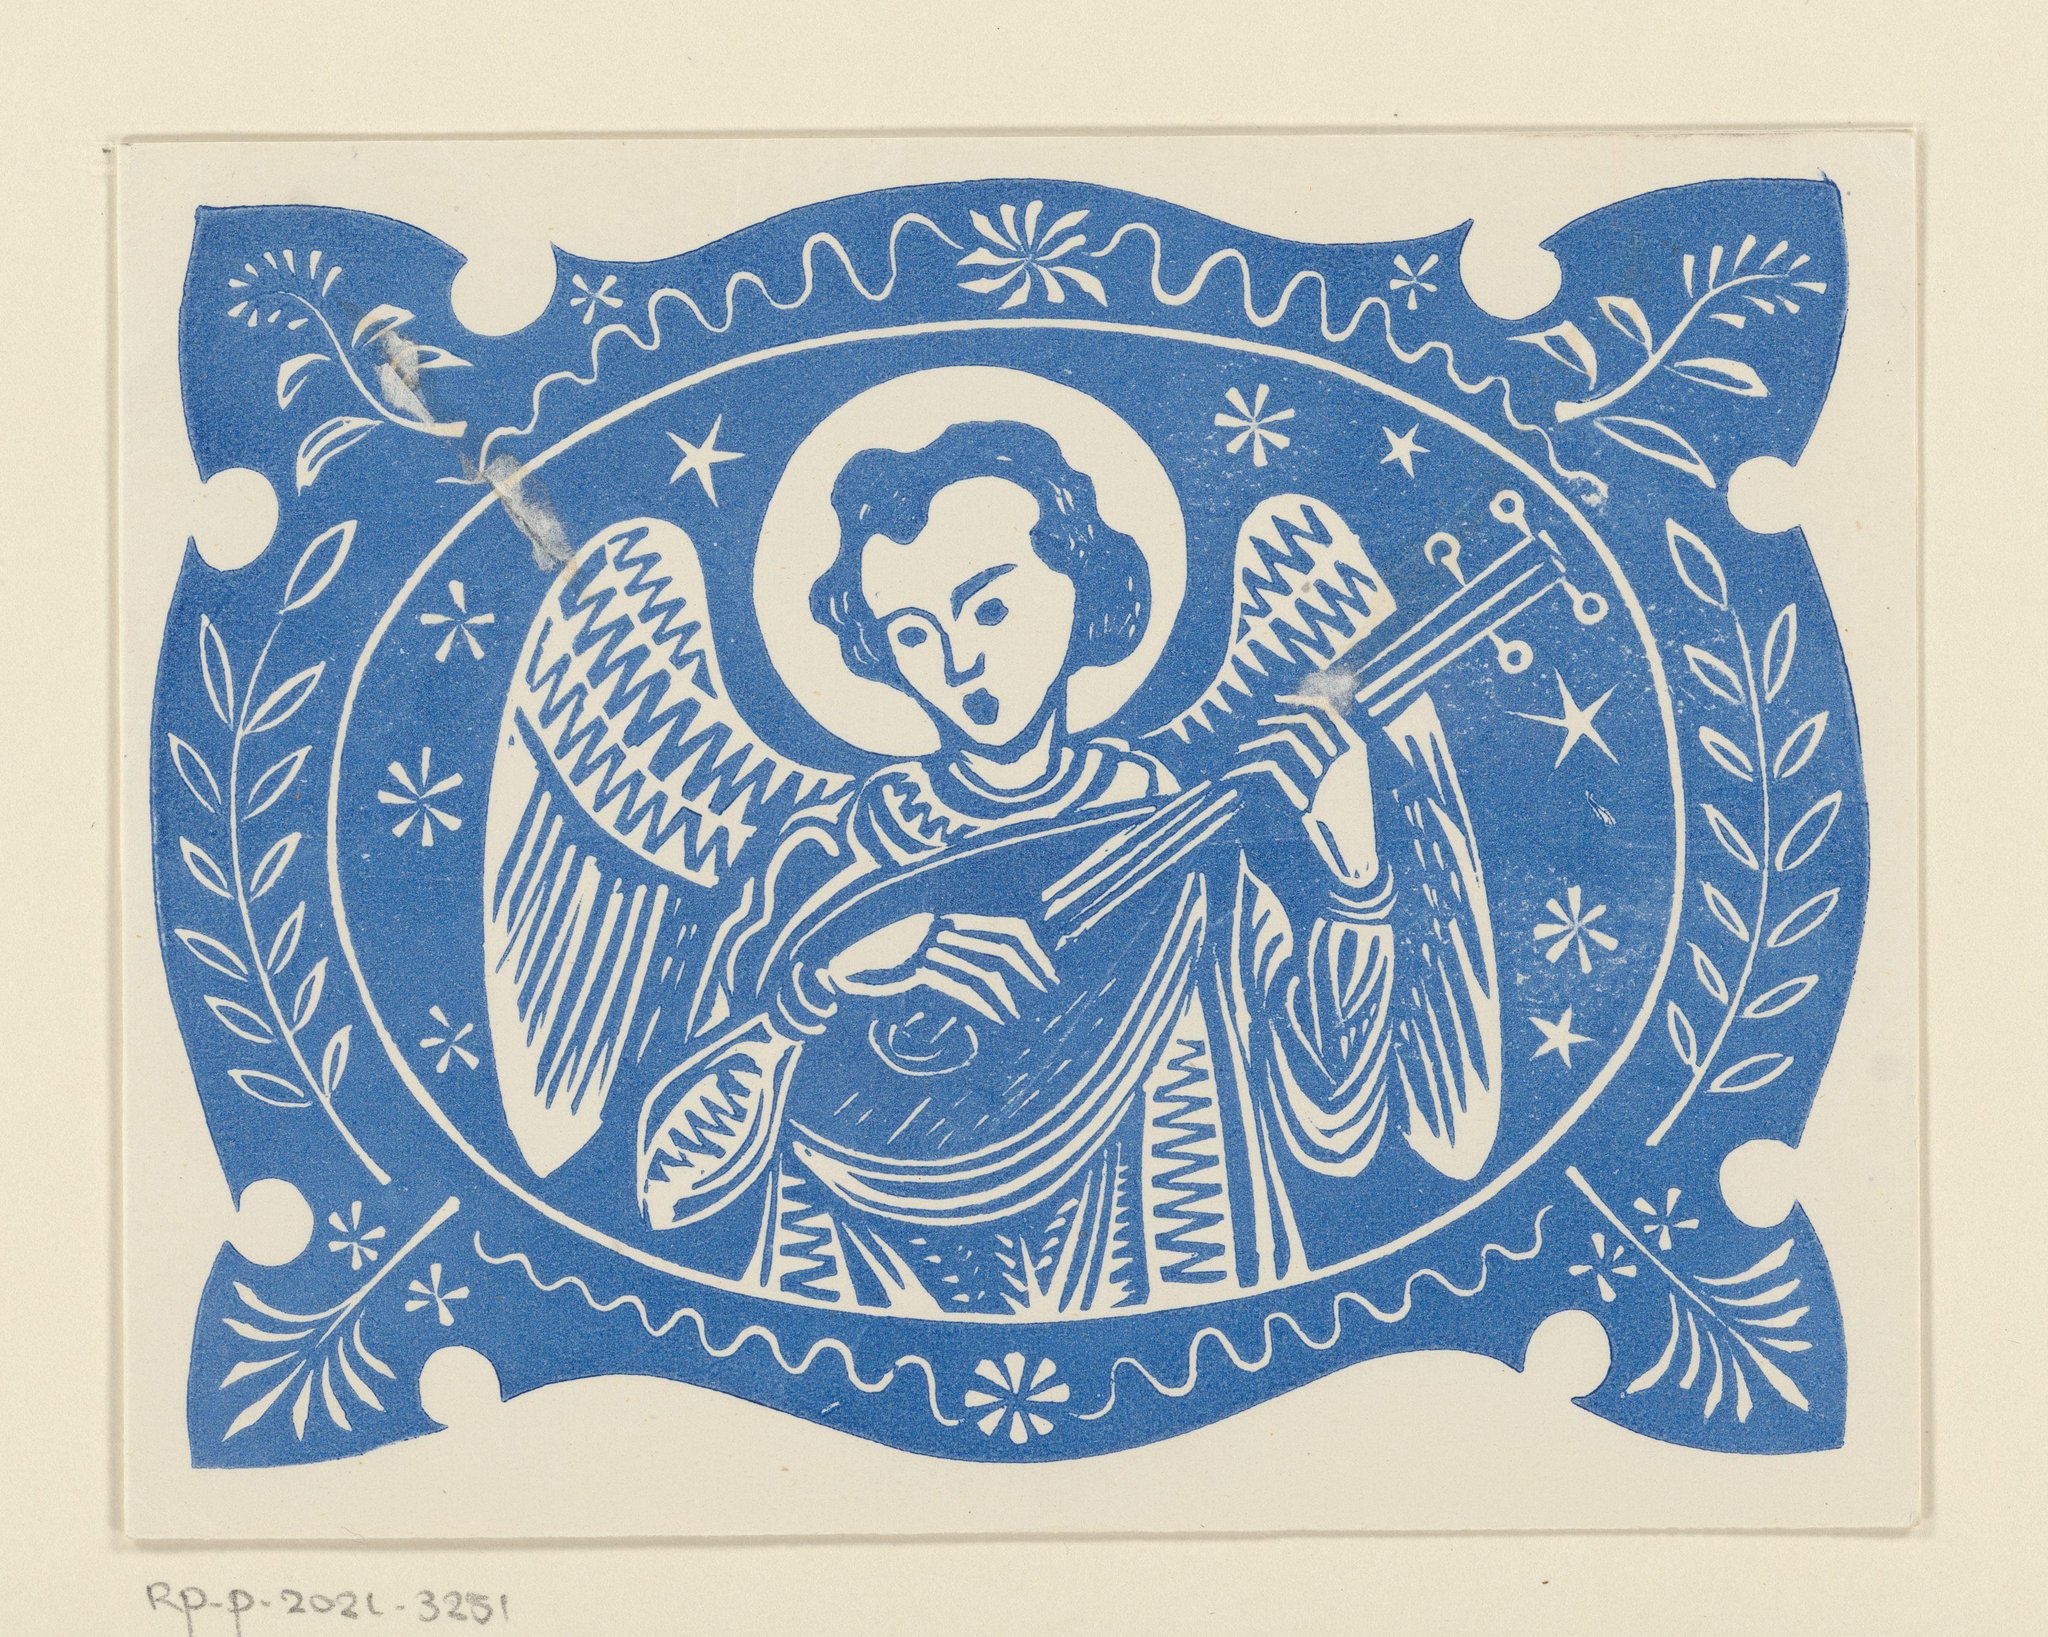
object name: new year card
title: Kerst- en nieuwjaarswens voor 1950-1951 van Irene en Alfred Brod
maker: Anonymous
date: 1950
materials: paper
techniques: woodcut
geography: london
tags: christmas card, lute, and special forms of lute, e.g.: theorbo, angels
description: Een luitspelende engel in decoratief kader. Binnenin links een handgeschreven persoonlijke boodschap aan 'Dear [...] Roell'. Binnenin rechts gedrukte tekst: 'With the Season's Greetings from Irene and Alfred Brod' en het adres van de afzenders.